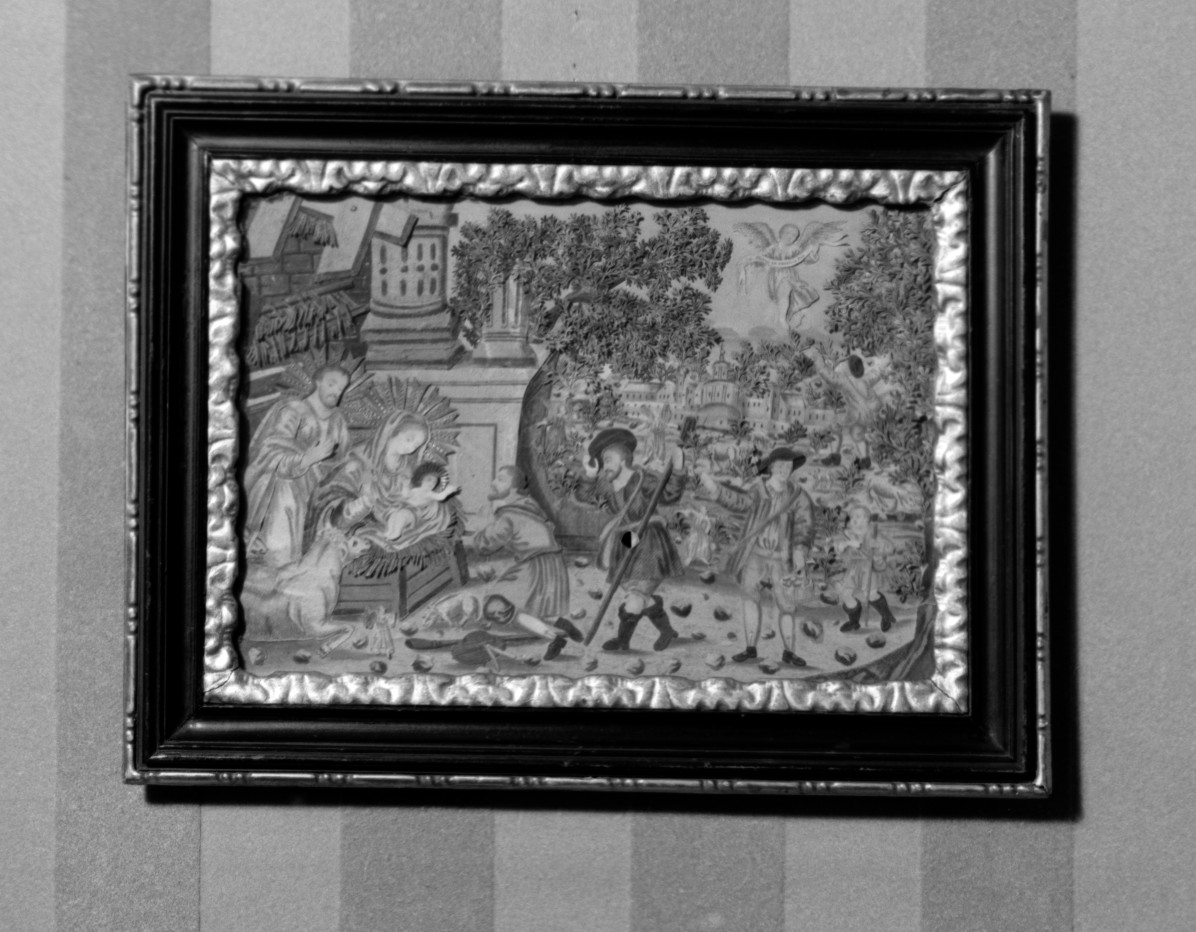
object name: collage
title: Adoration of the Shepherds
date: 1701-1800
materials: glass, paper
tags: adoration of the shepherds